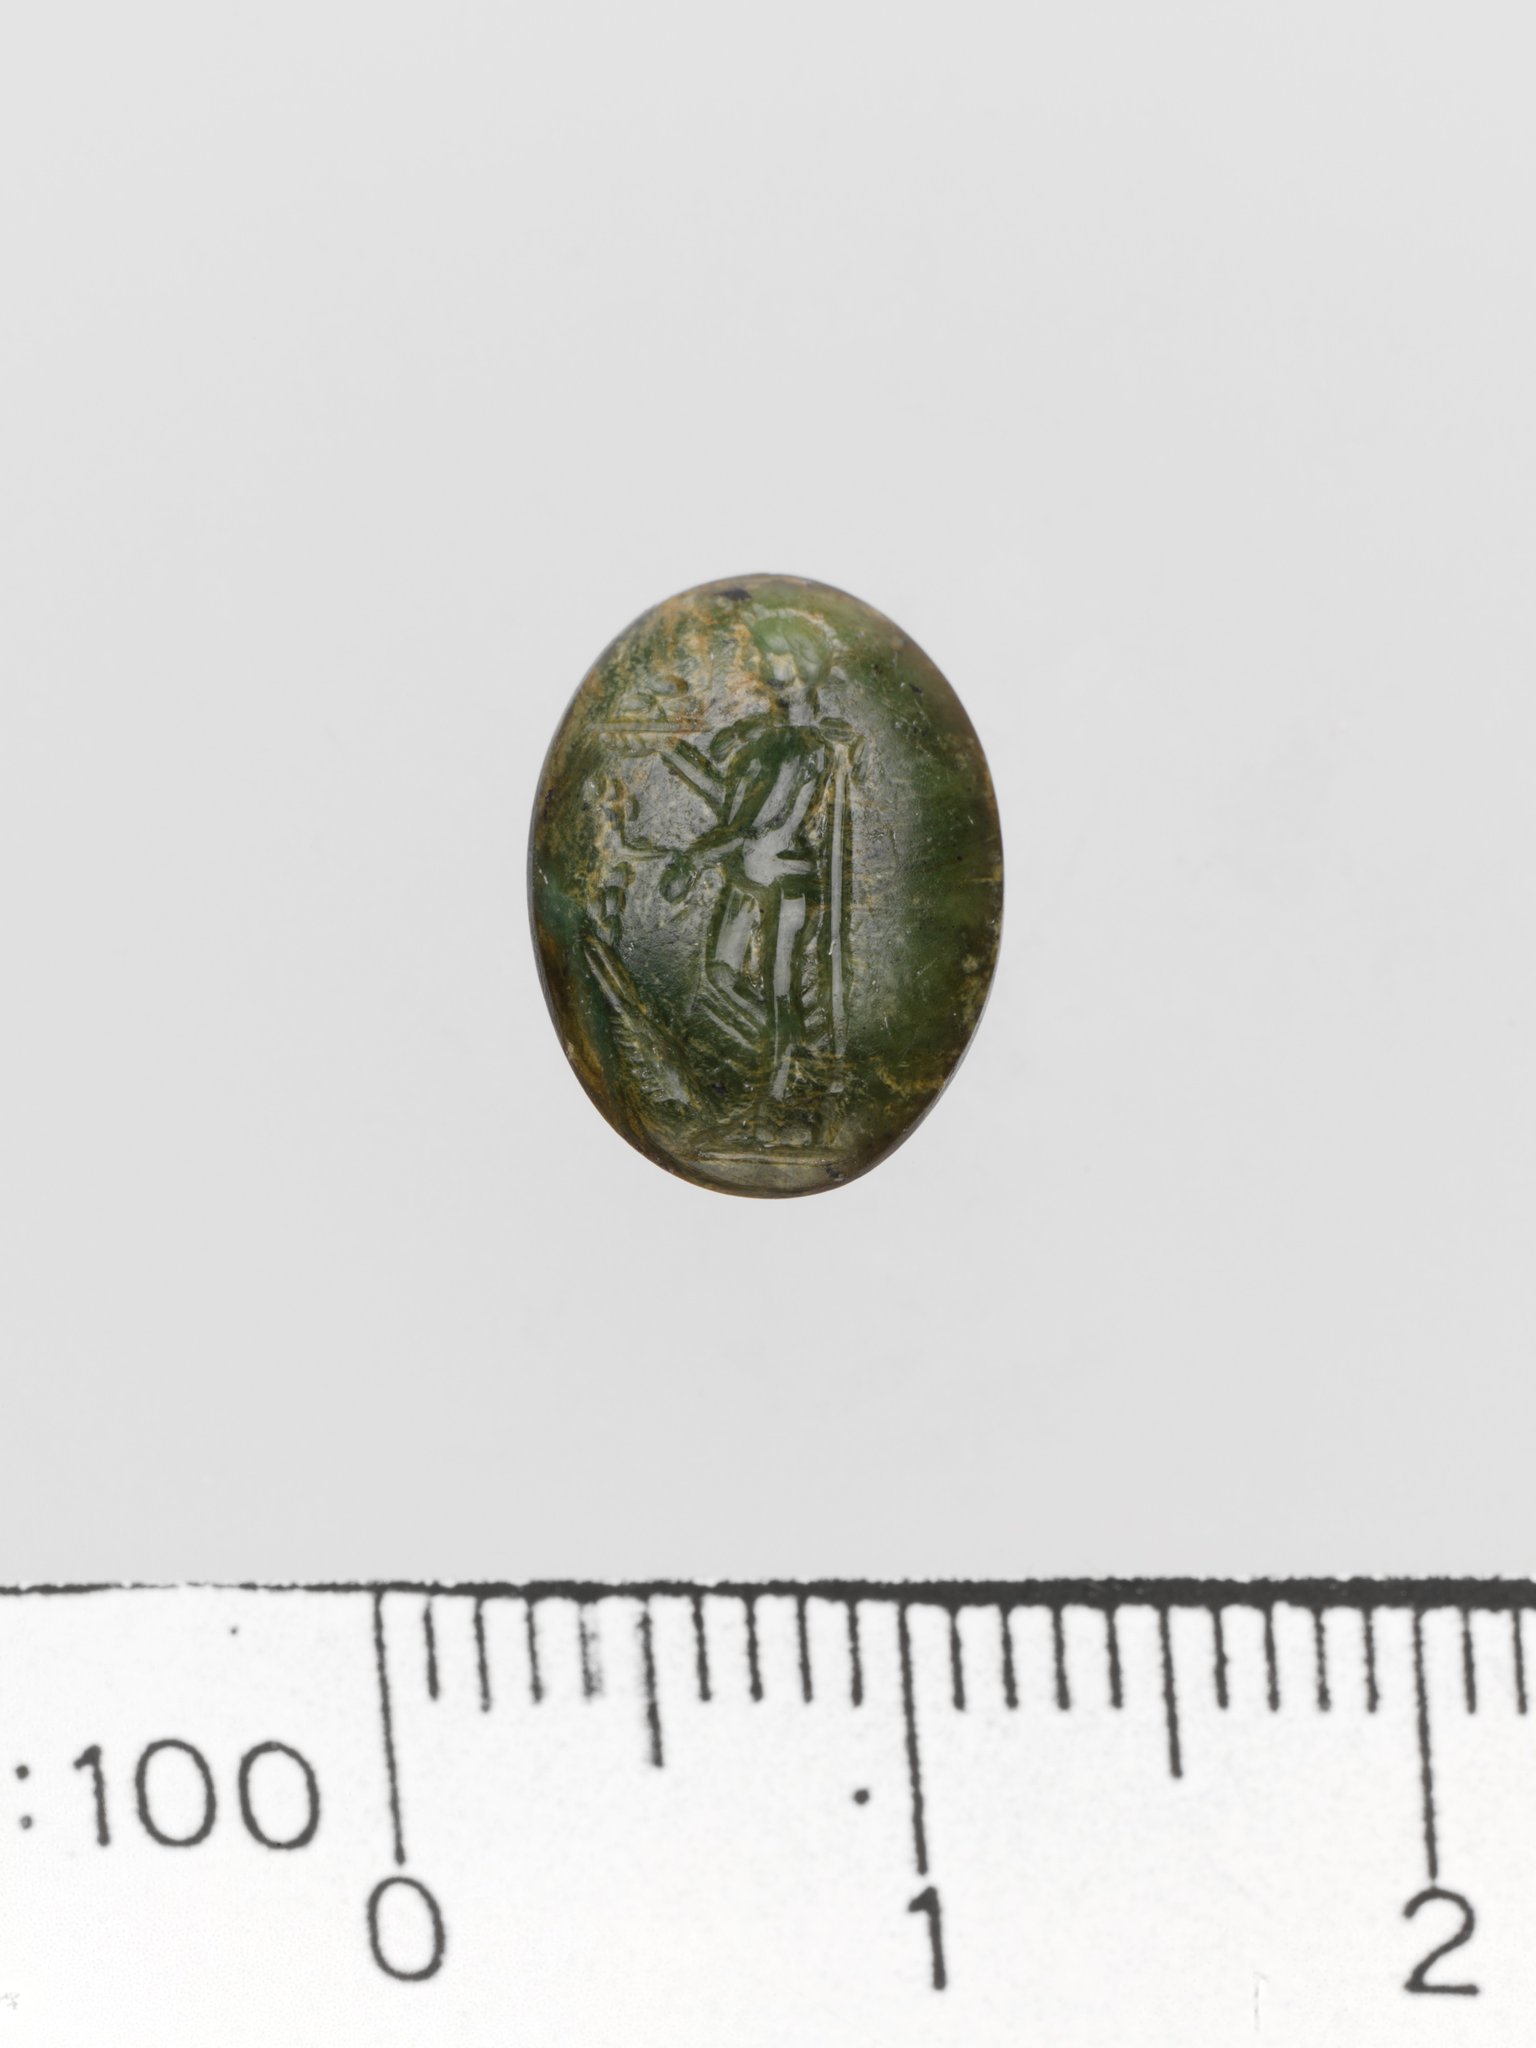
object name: intaglio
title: Plasma ring stone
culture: roman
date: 1-100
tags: men